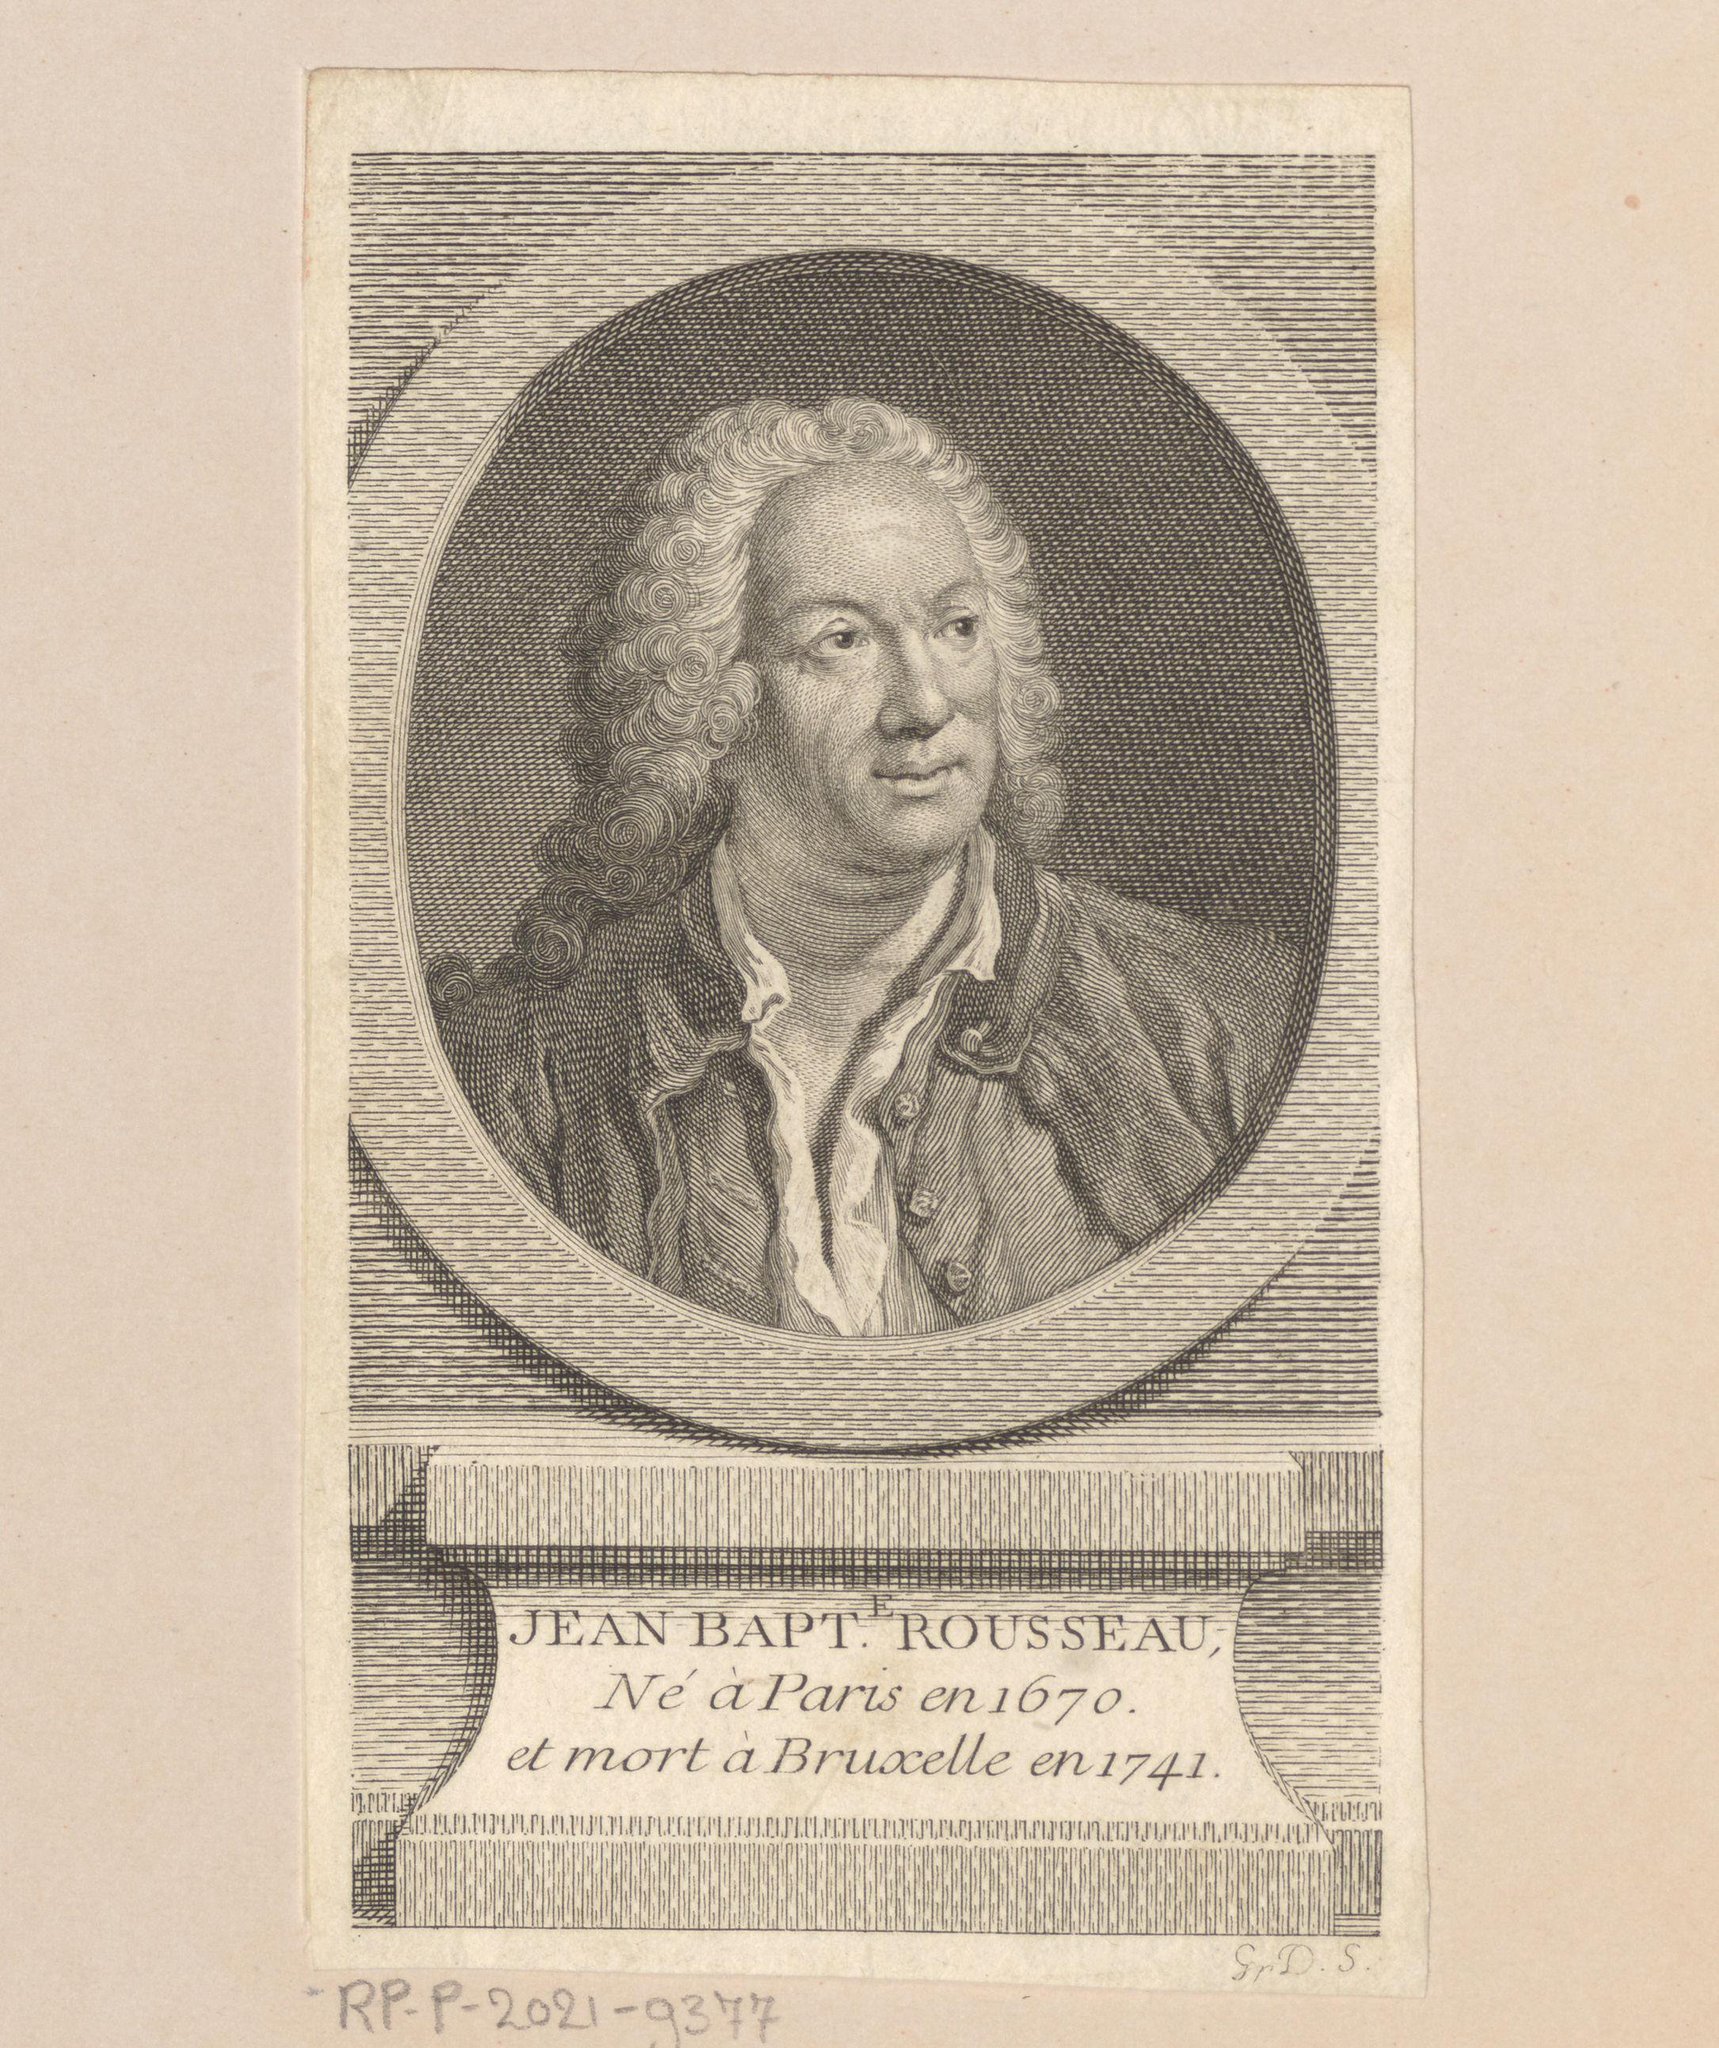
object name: print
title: Portret van Jean Baptiste Rousseau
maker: Anonymous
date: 1748-1753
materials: paper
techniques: engraving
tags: paris, brussels, jean baptiste rousseau (1669-1741), historical persons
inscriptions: signature: ‘G.D.S.’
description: Prent mogelijk uit: Rousseau, Jean Baptiste. Oeuvres de Rousseau. Londen: s.n., 1748. Of een latere editie (1753).